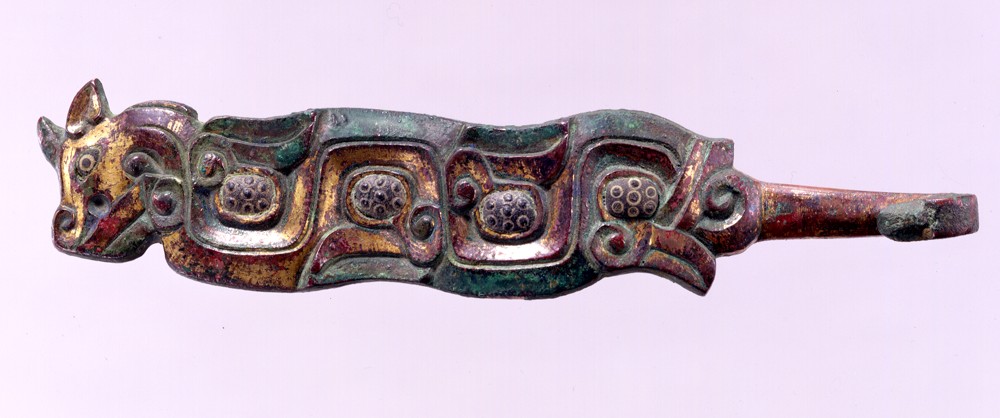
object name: belt hook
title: Belt Hook in the Shape of a Horned Dragon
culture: north chinese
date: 300-1 BCE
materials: bronze, glass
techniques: gilding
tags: dragons